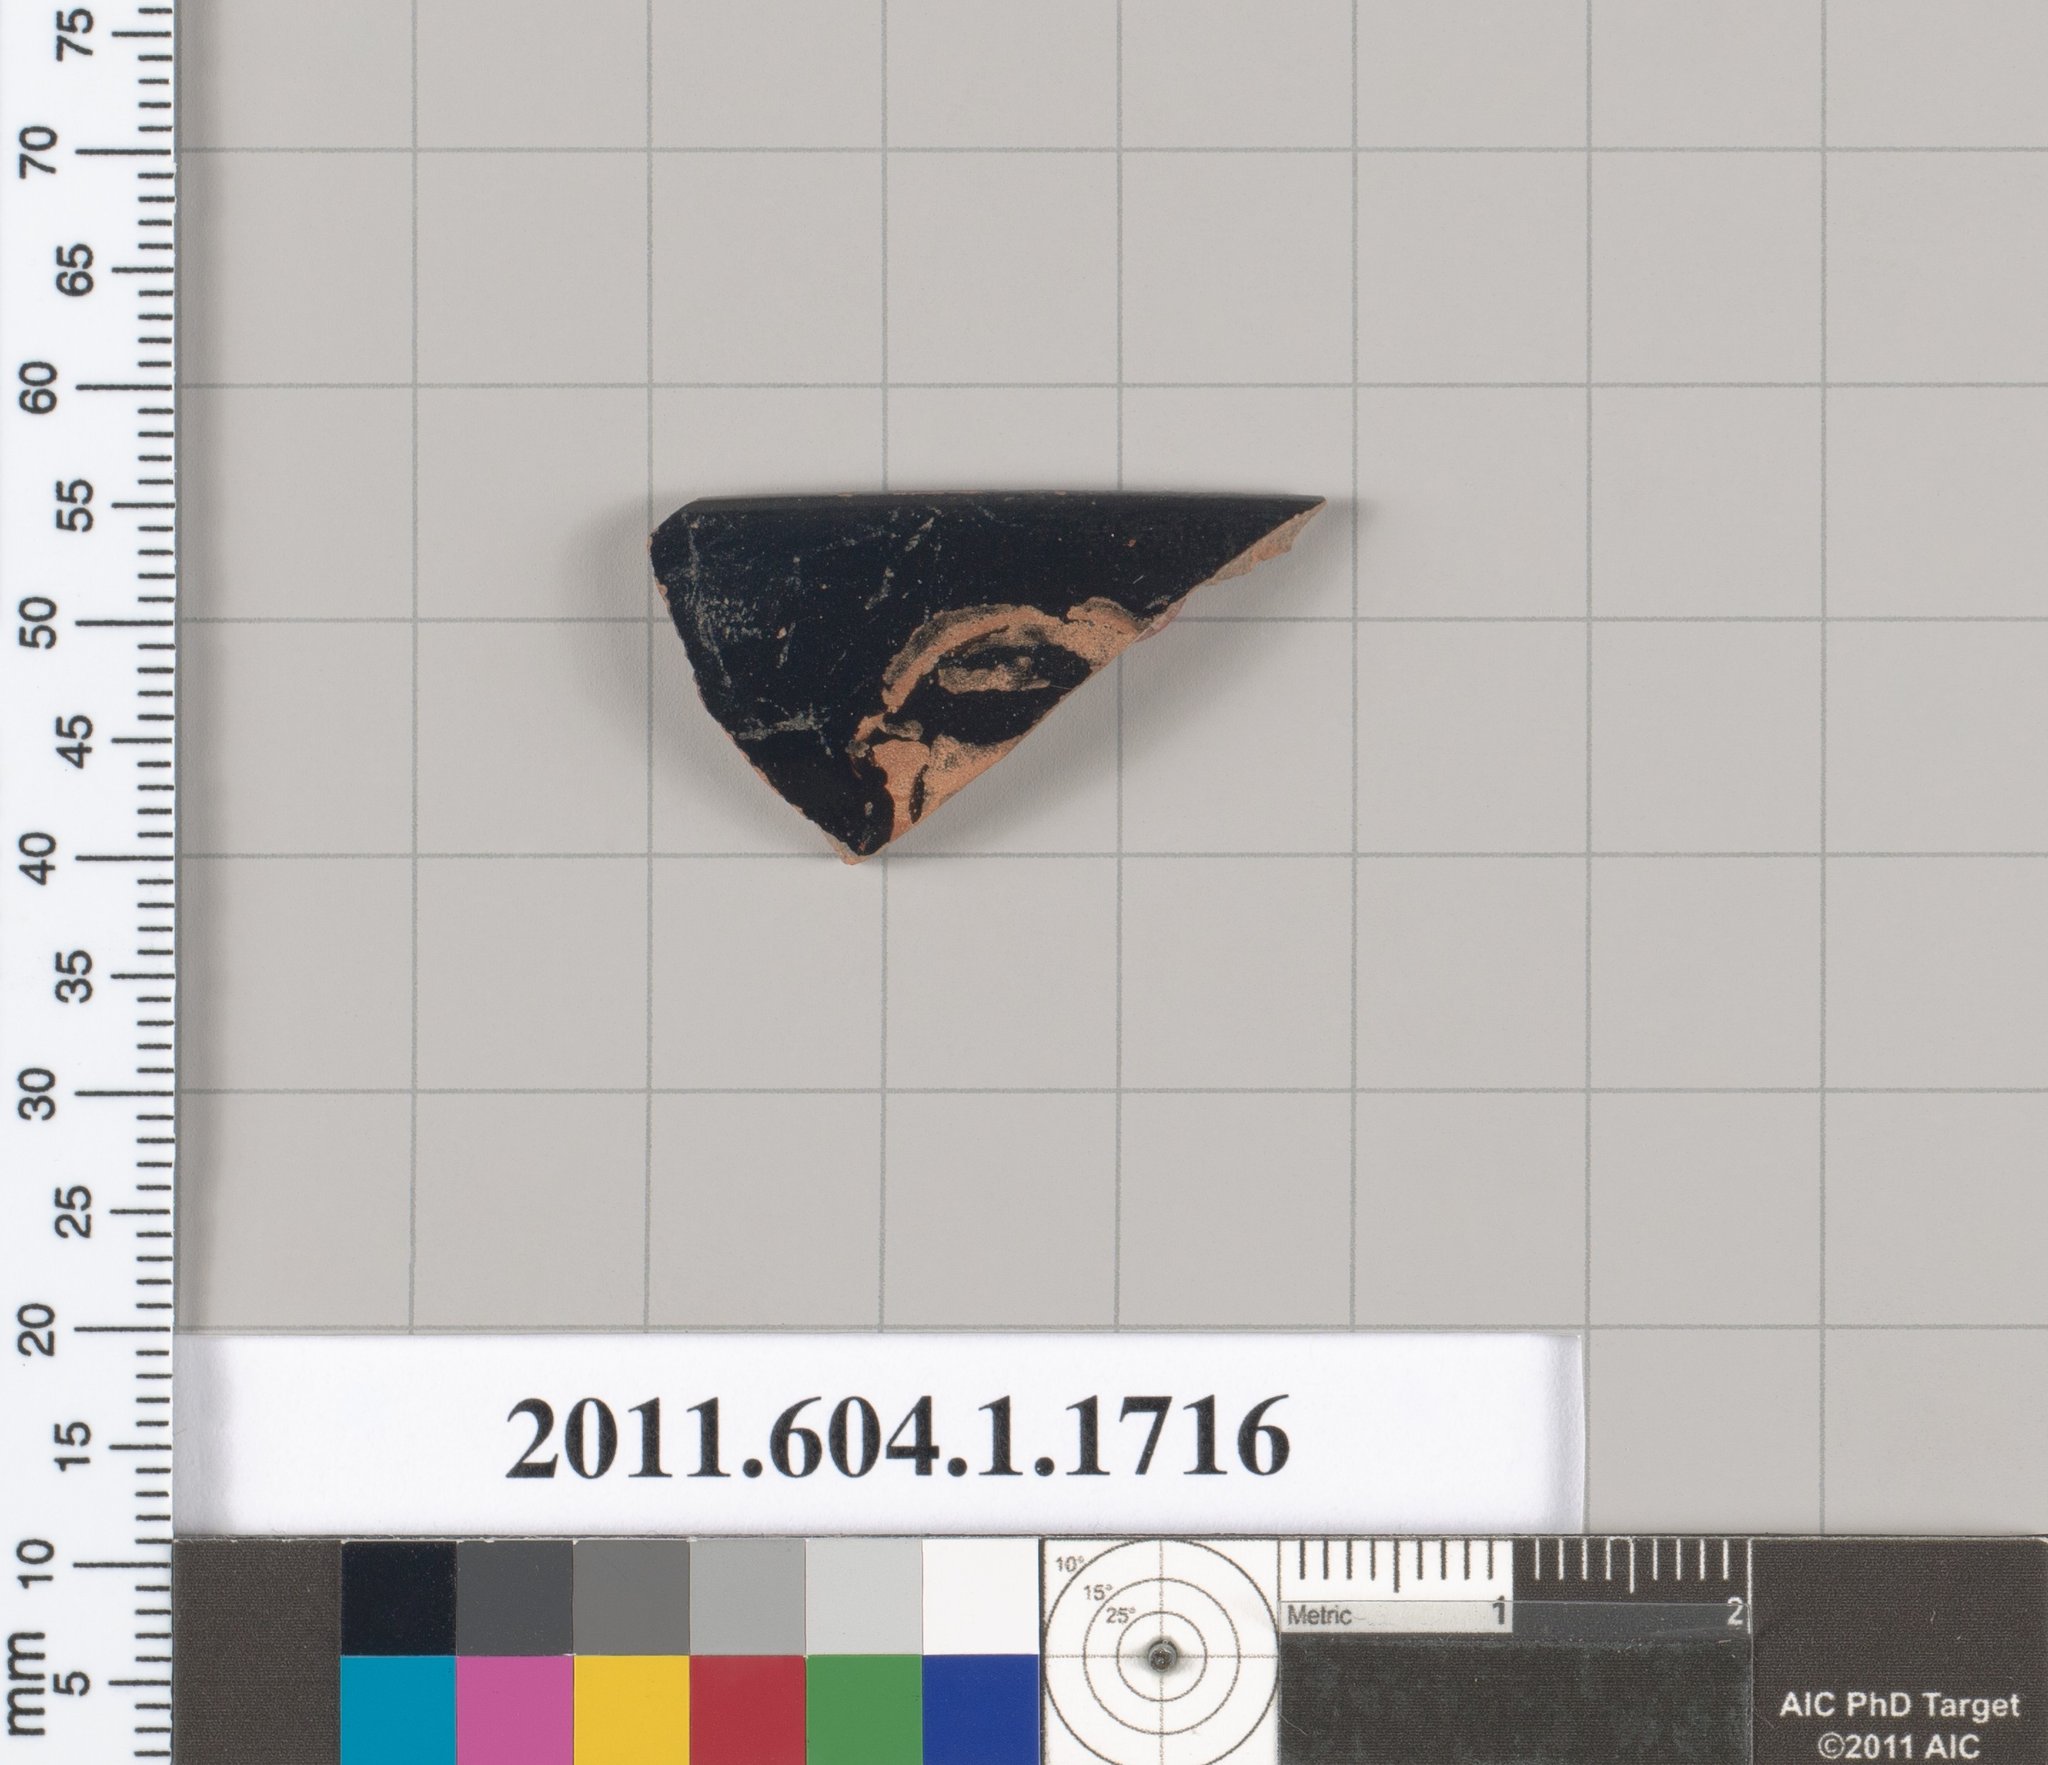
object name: kylix fragment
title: Terracotta rim fragment of a kylix (drinking cup)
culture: greek, attic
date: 467-435 BCE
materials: terracotta